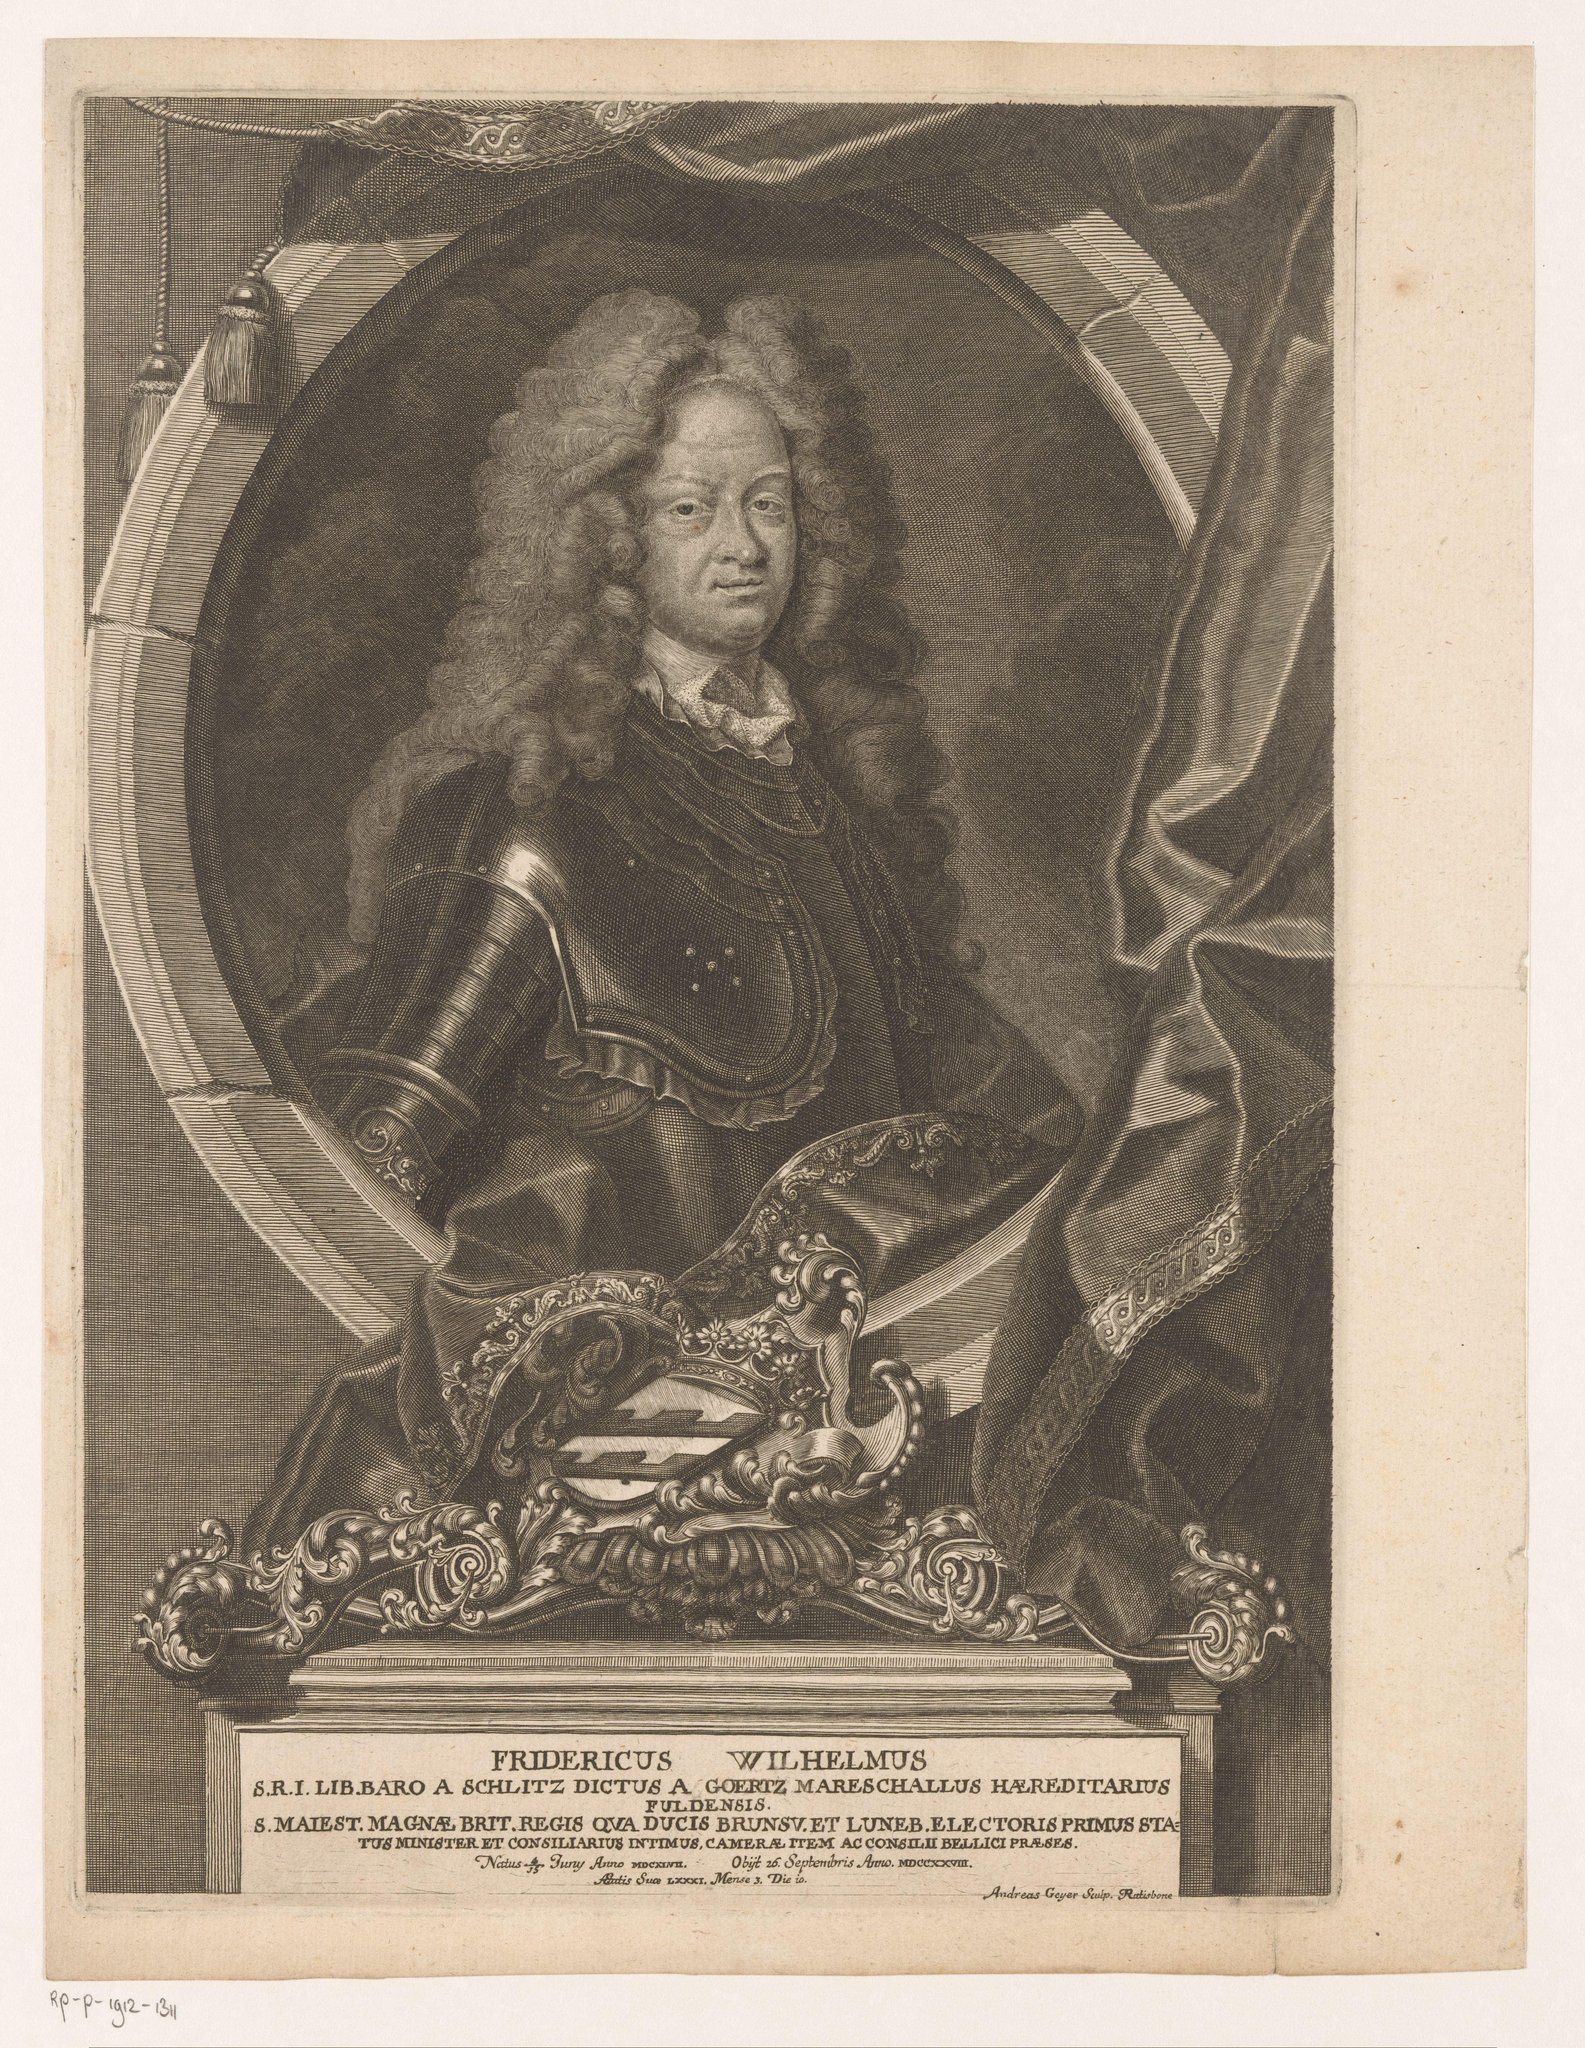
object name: print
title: Portret van Friedrich Wilhelm Graf von Görtz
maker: andreas geyer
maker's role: print maker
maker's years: -1729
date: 1728-1729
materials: paper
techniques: engraving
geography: regensburg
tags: ornament ~ medallion, armour, historical persons, armorial bearing, heraldry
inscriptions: collector's mark: Lugt 2228